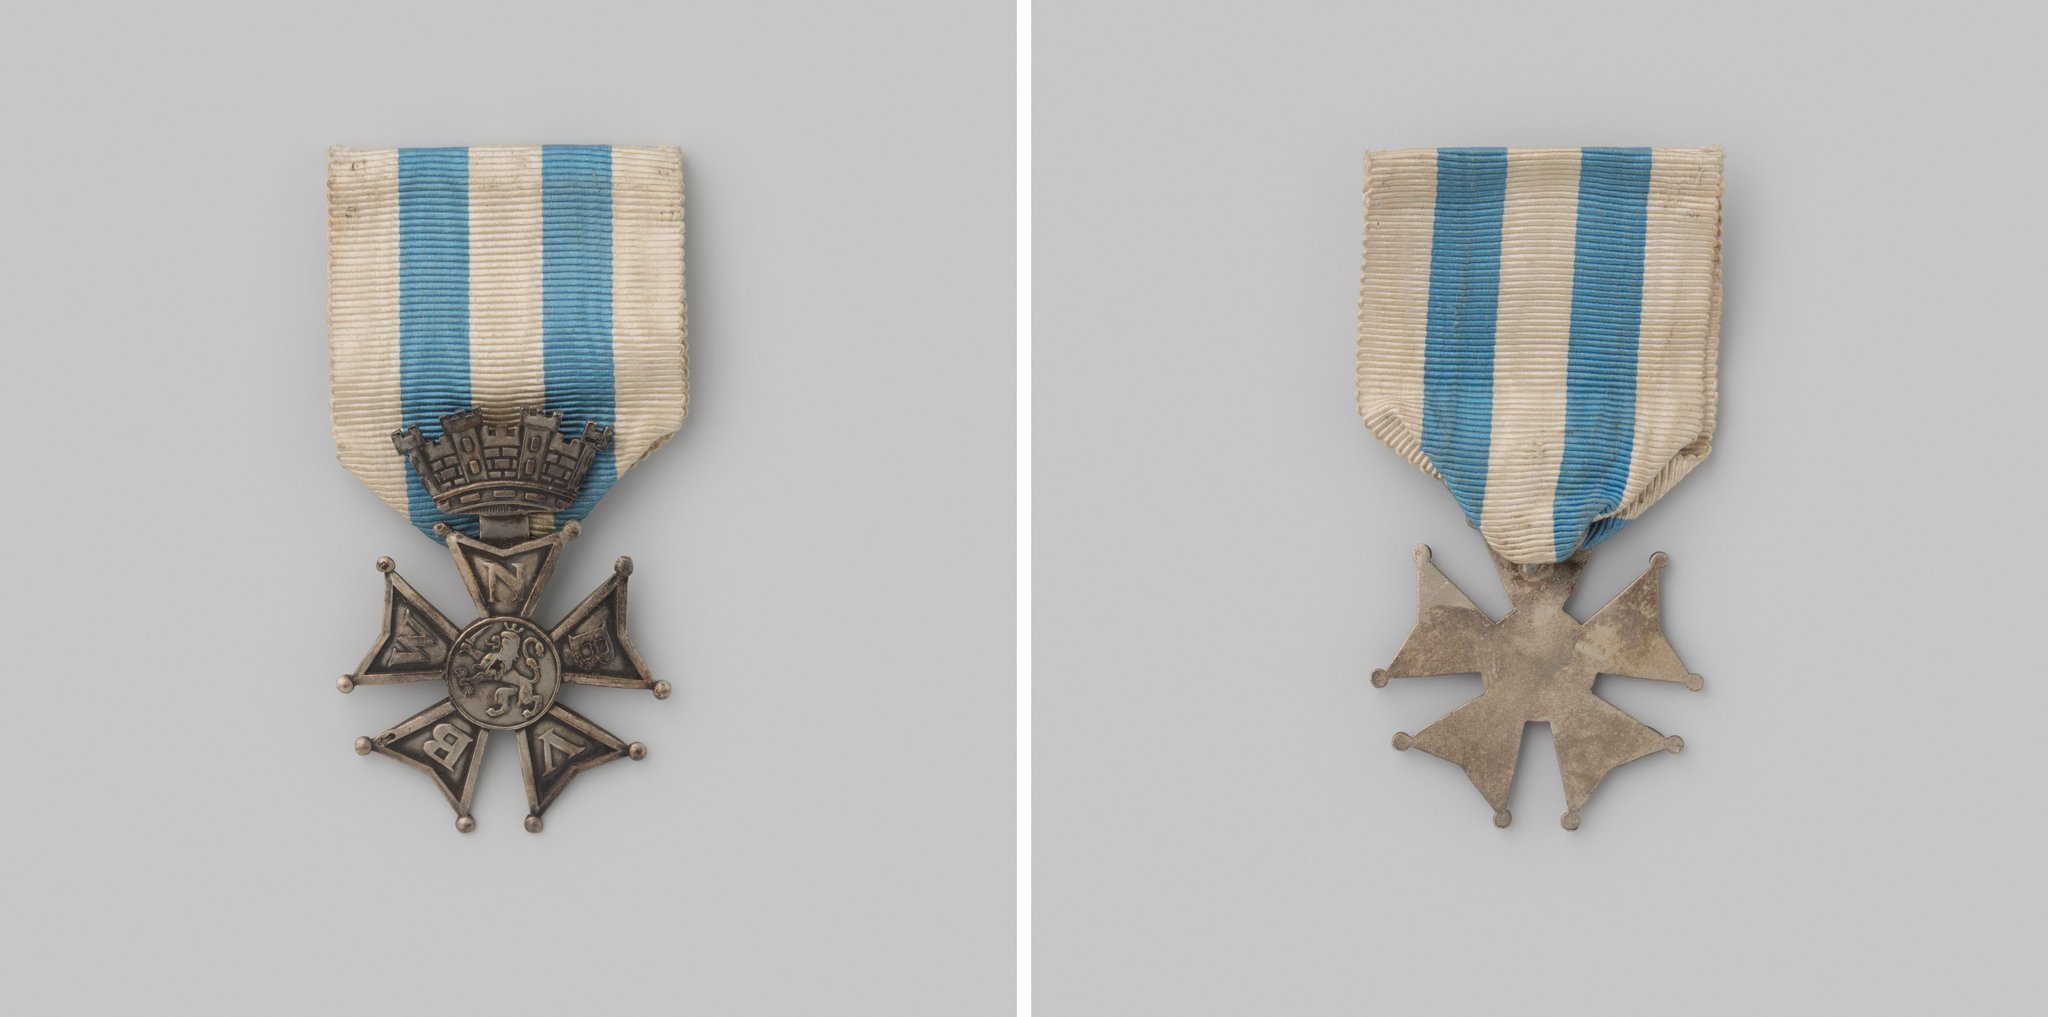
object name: ereteken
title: Kruis van Verdienste van de Nederlandse Bond van Vrijwillige Burgerwachten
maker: Anonymous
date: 1924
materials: silver, textile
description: Zilveren kruis met vijf armen, kroon met scharnier en gesp voor bevestiging aan het lint. Voorzijde: Op de armen van het zilveren kruis is de afkorting "N B V B W" geplaatst. In het midden van het kruis is een rond schild afgebeeld waarop een klimmende leeuw met zwaard en pijlenbundel, als in het rijkswapen, is afgebeeld. Met Romeinse stedenkroon of muurkroon.